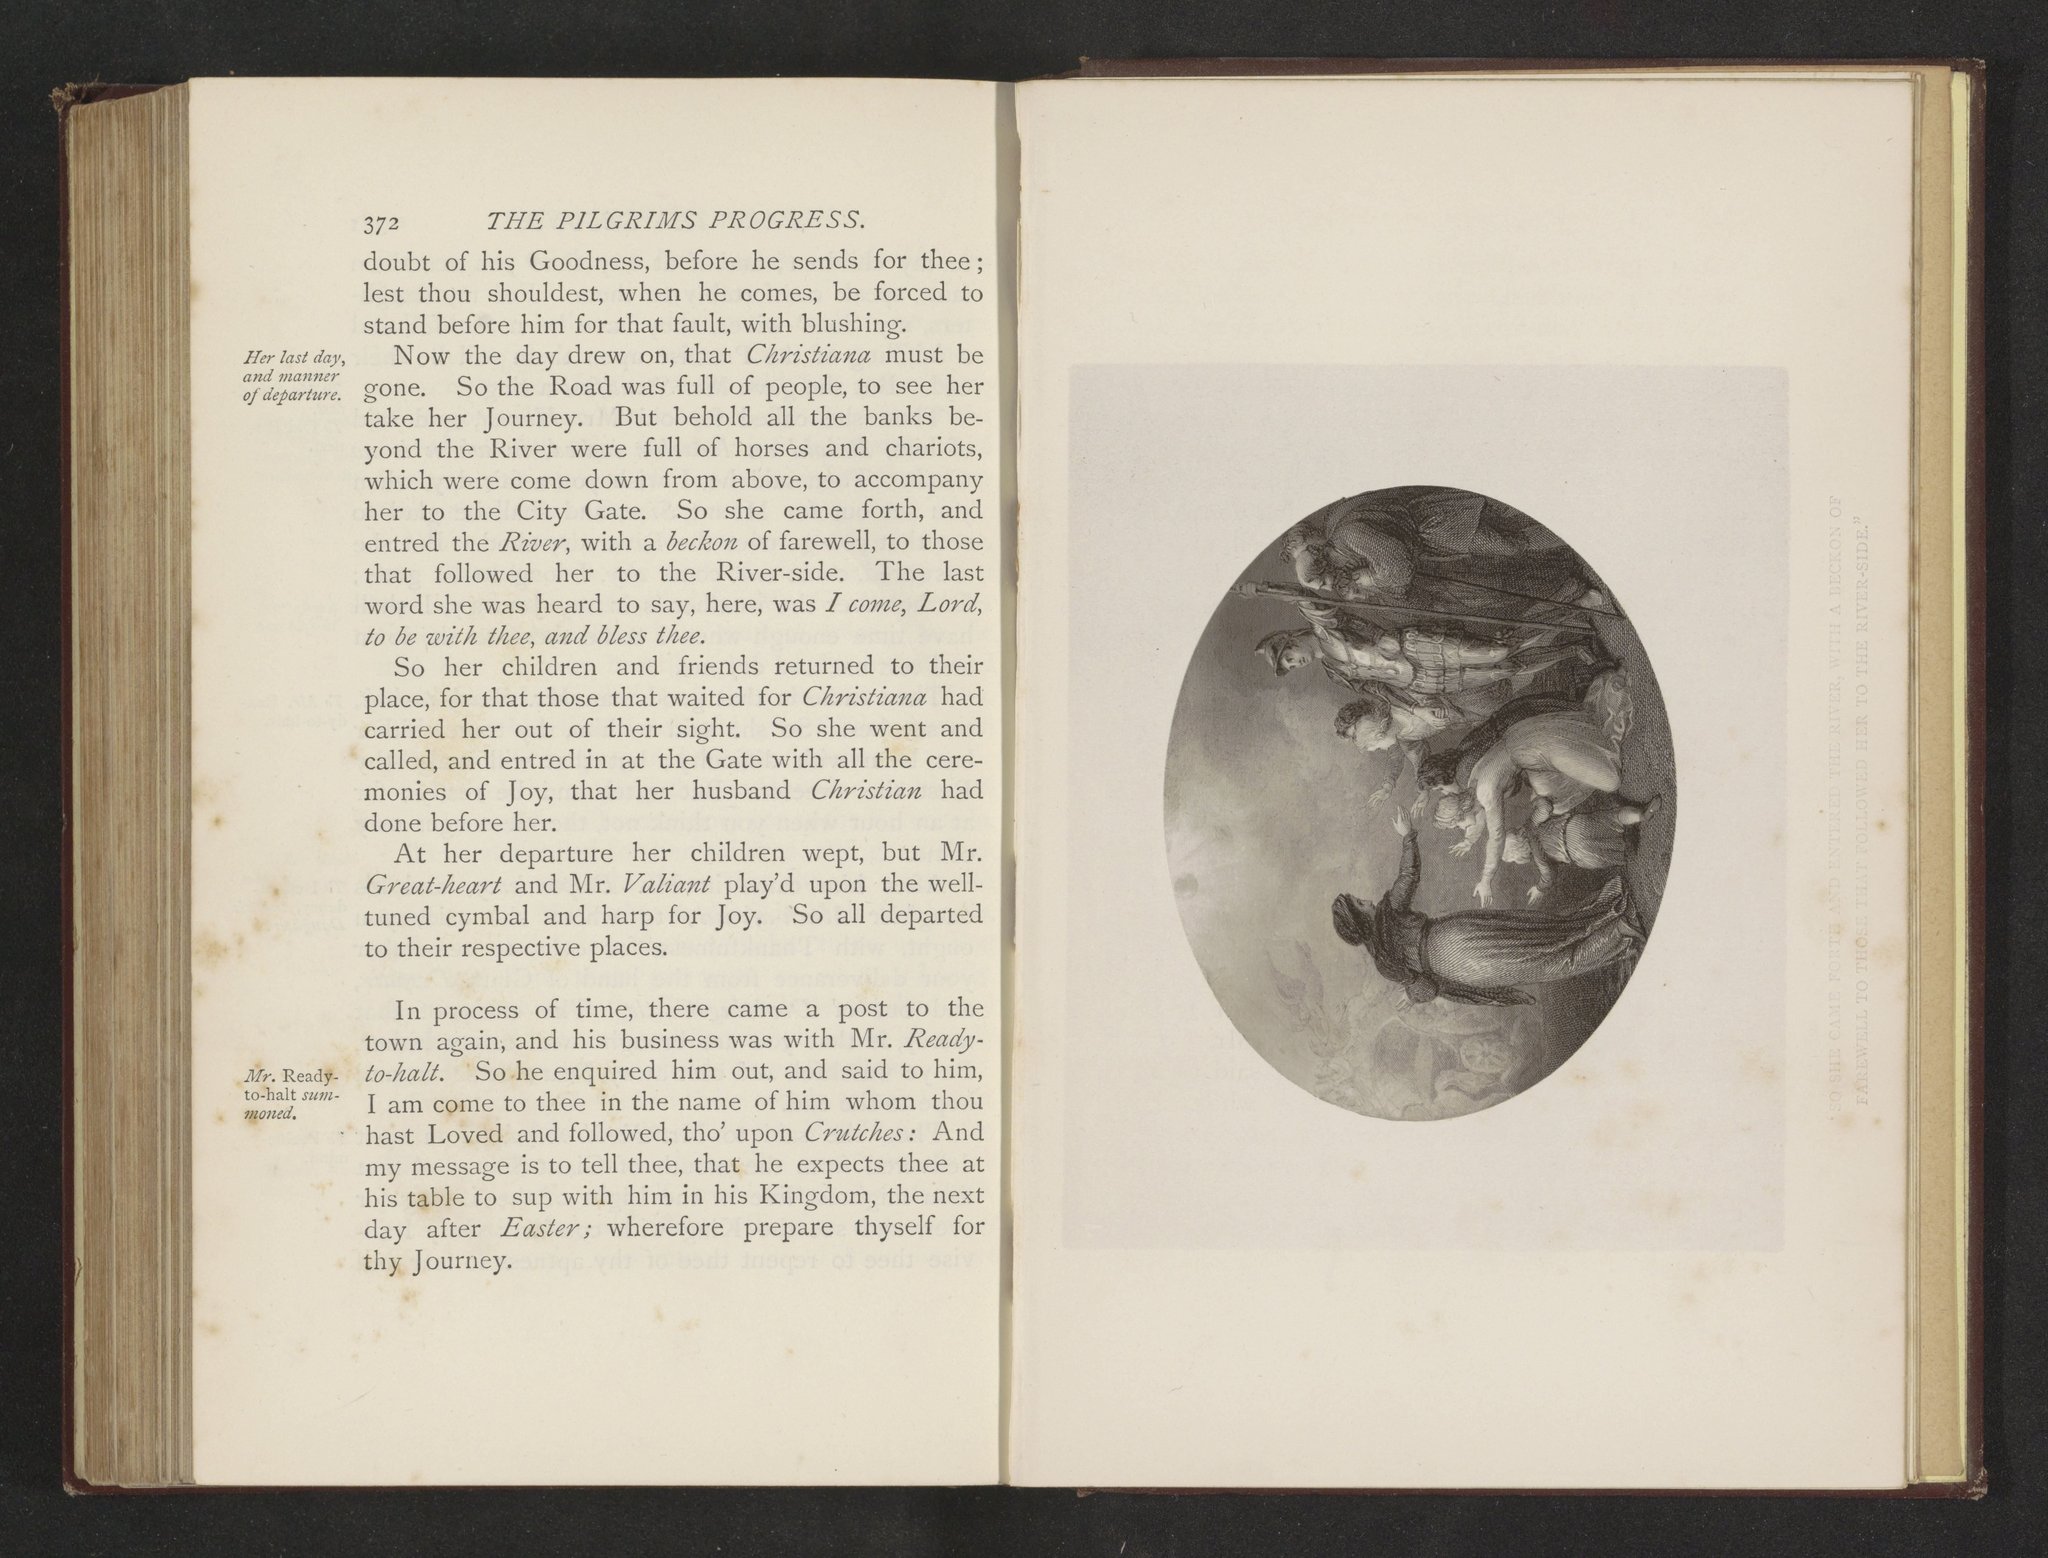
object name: reproduction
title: Fotoreproductie van een illustratie door Thomas Stothard voor Eens Christens reize naar de Eeuwigheid door John Bunyan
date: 1871-1881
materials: paper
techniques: woodburytype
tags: print, e.g.: engraving, etching, lithograph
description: Illustratie betreft een gezelschap aan de oever van een rivier.